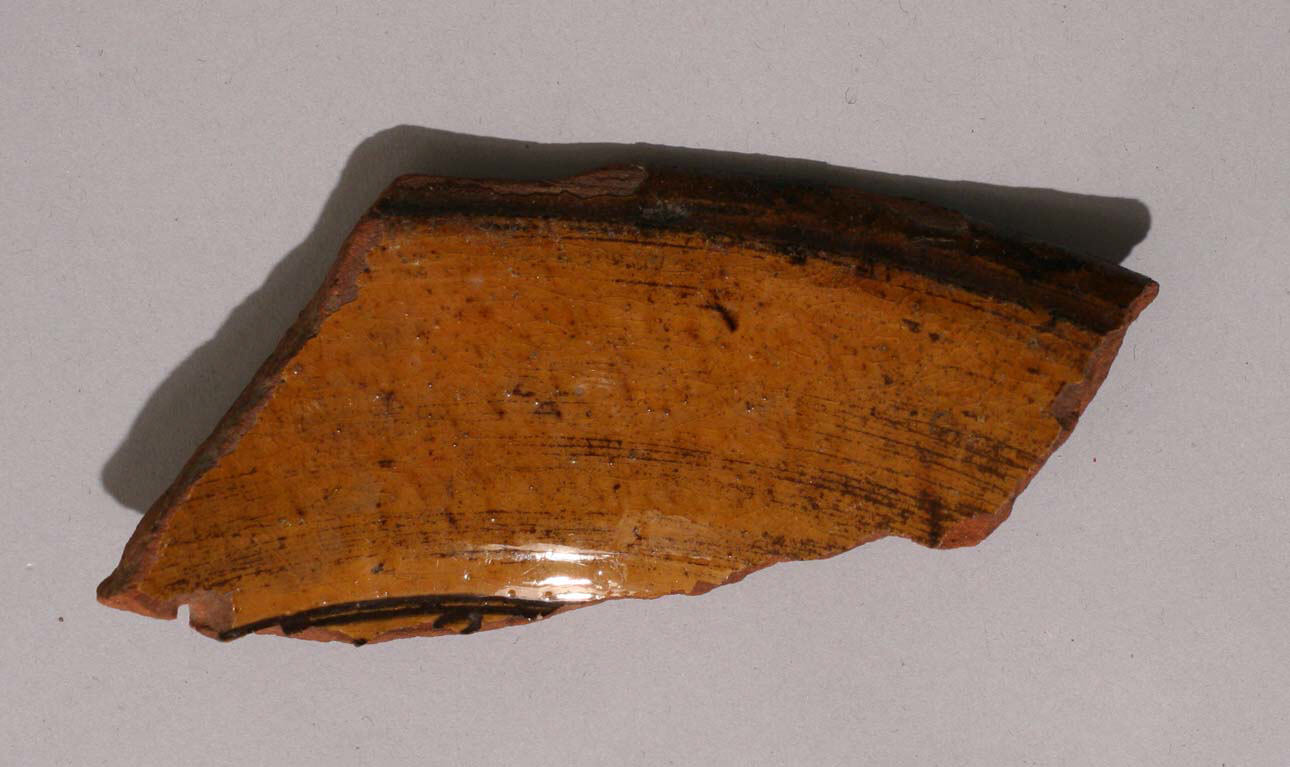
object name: ceramic fragment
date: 1301-1500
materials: earthenware, glaze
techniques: coloring, incising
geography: egypt